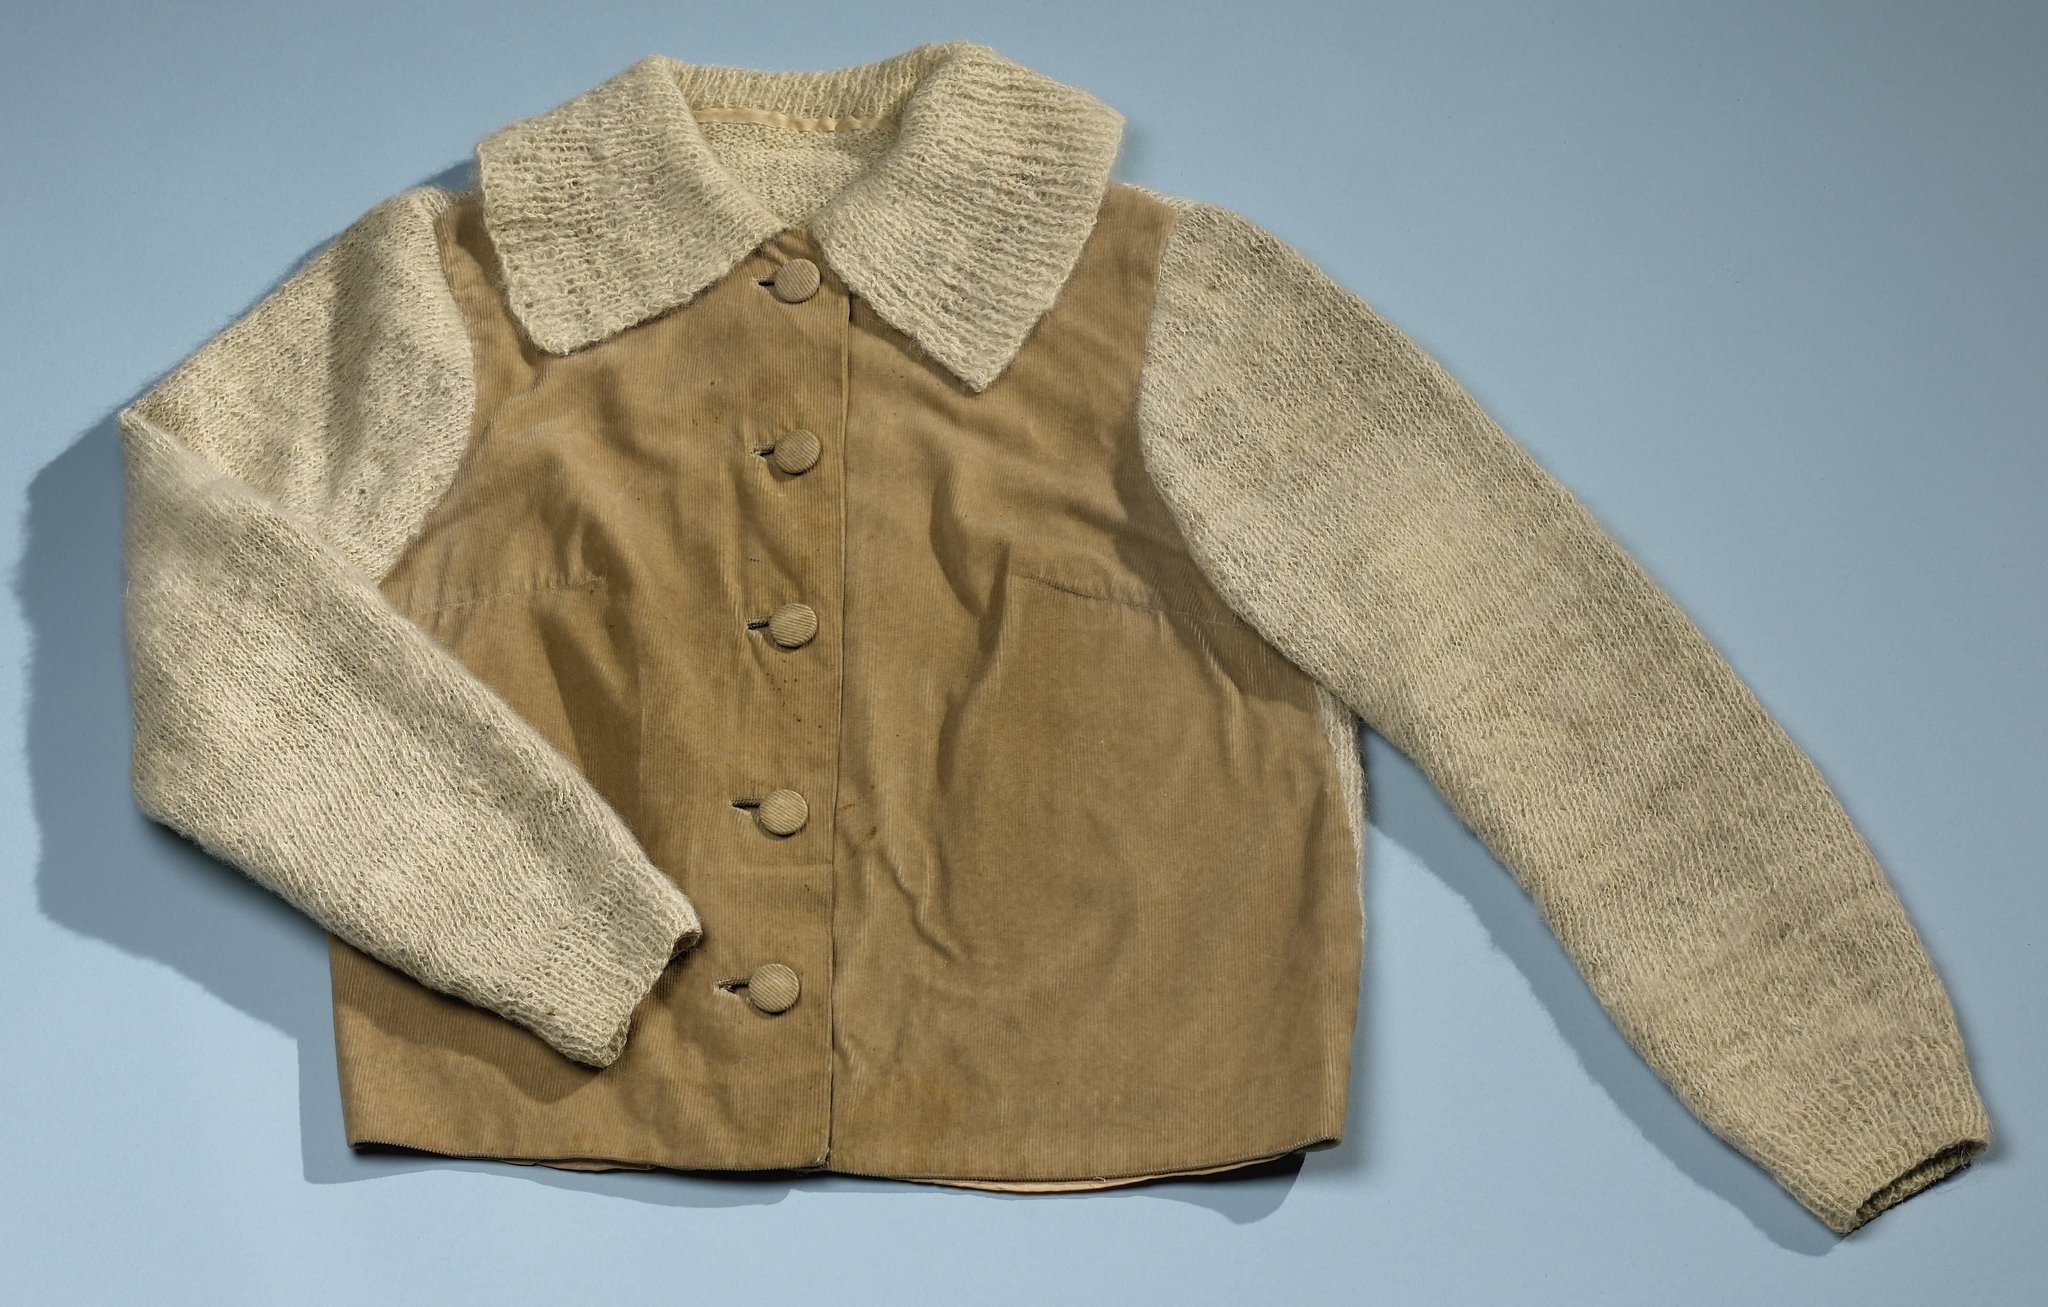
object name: coat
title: Jas van ribfluweel en hondehaar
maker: ans talma van griethuysen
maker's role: kleermaker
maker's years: 1896-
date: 1944-1945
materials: textile, hair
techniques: knitting, sewing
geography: netherlands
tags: netherlands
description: Jasje, gemaakt in 1944-1945 voor Annejet Talma. Voorpand gemaakt van beige ribfluweel. Achterpand, mouwen en kraag gebreid van zelf gesponnen hondehaar.